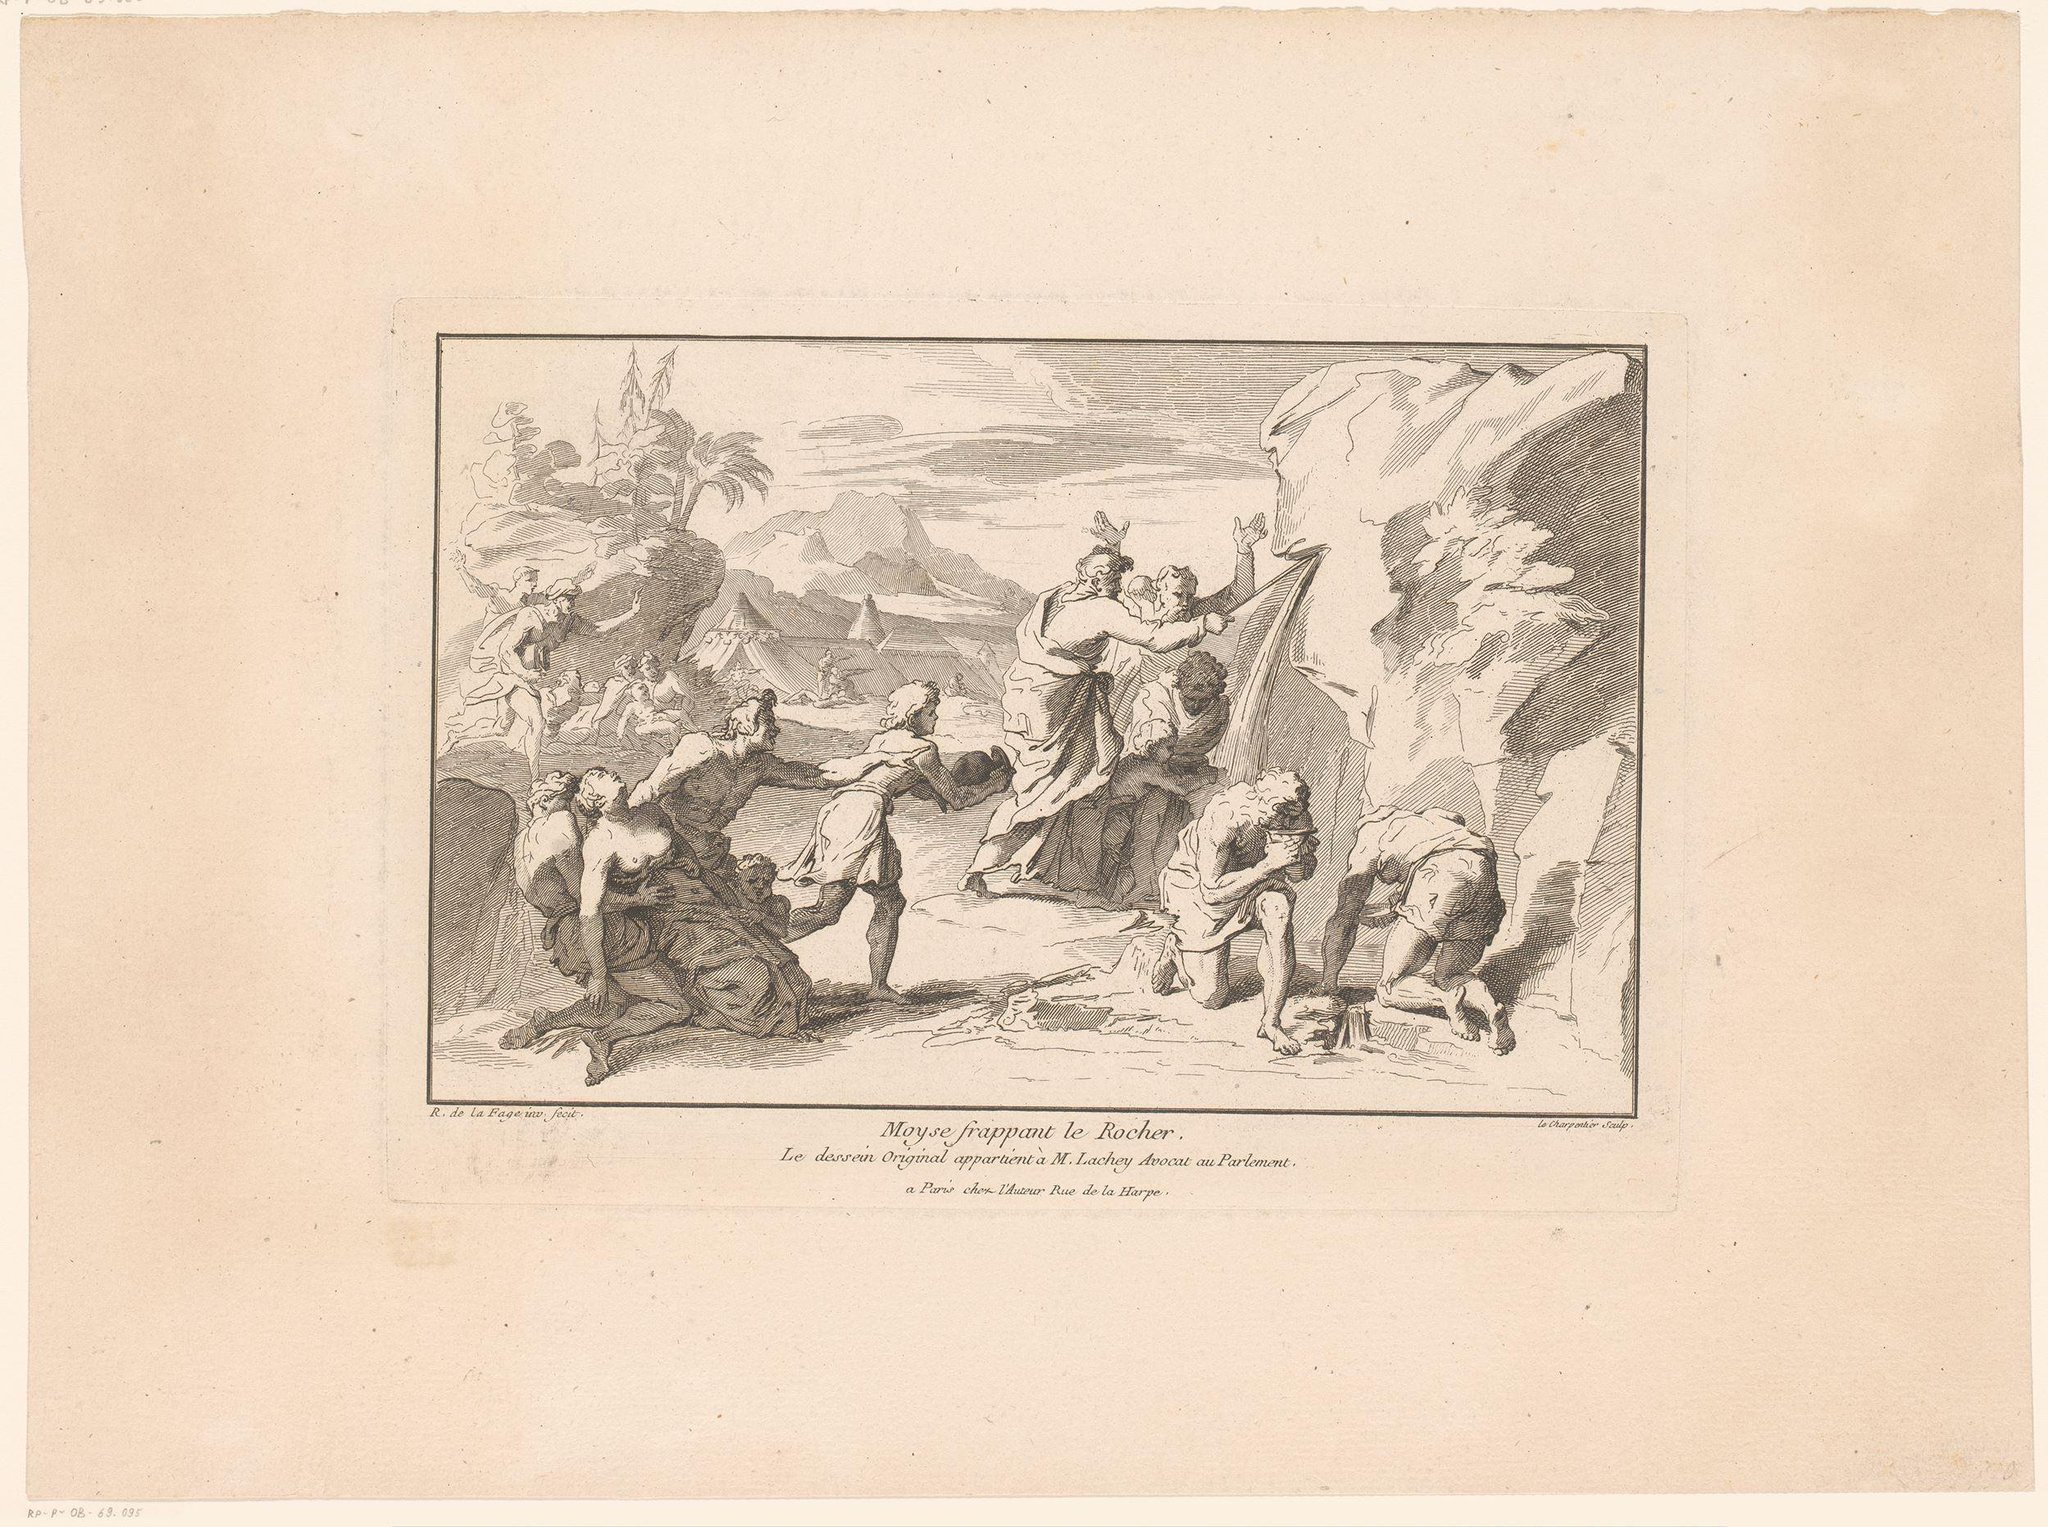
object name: print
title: Mozes slaat water uit de rots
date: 1743-1770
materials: paper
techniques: engraving, etching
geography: paris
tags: moses striking water from the rock (exodus 17:1-7; numbers 20:2-13)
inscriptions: collector's mark: Lugt 2165